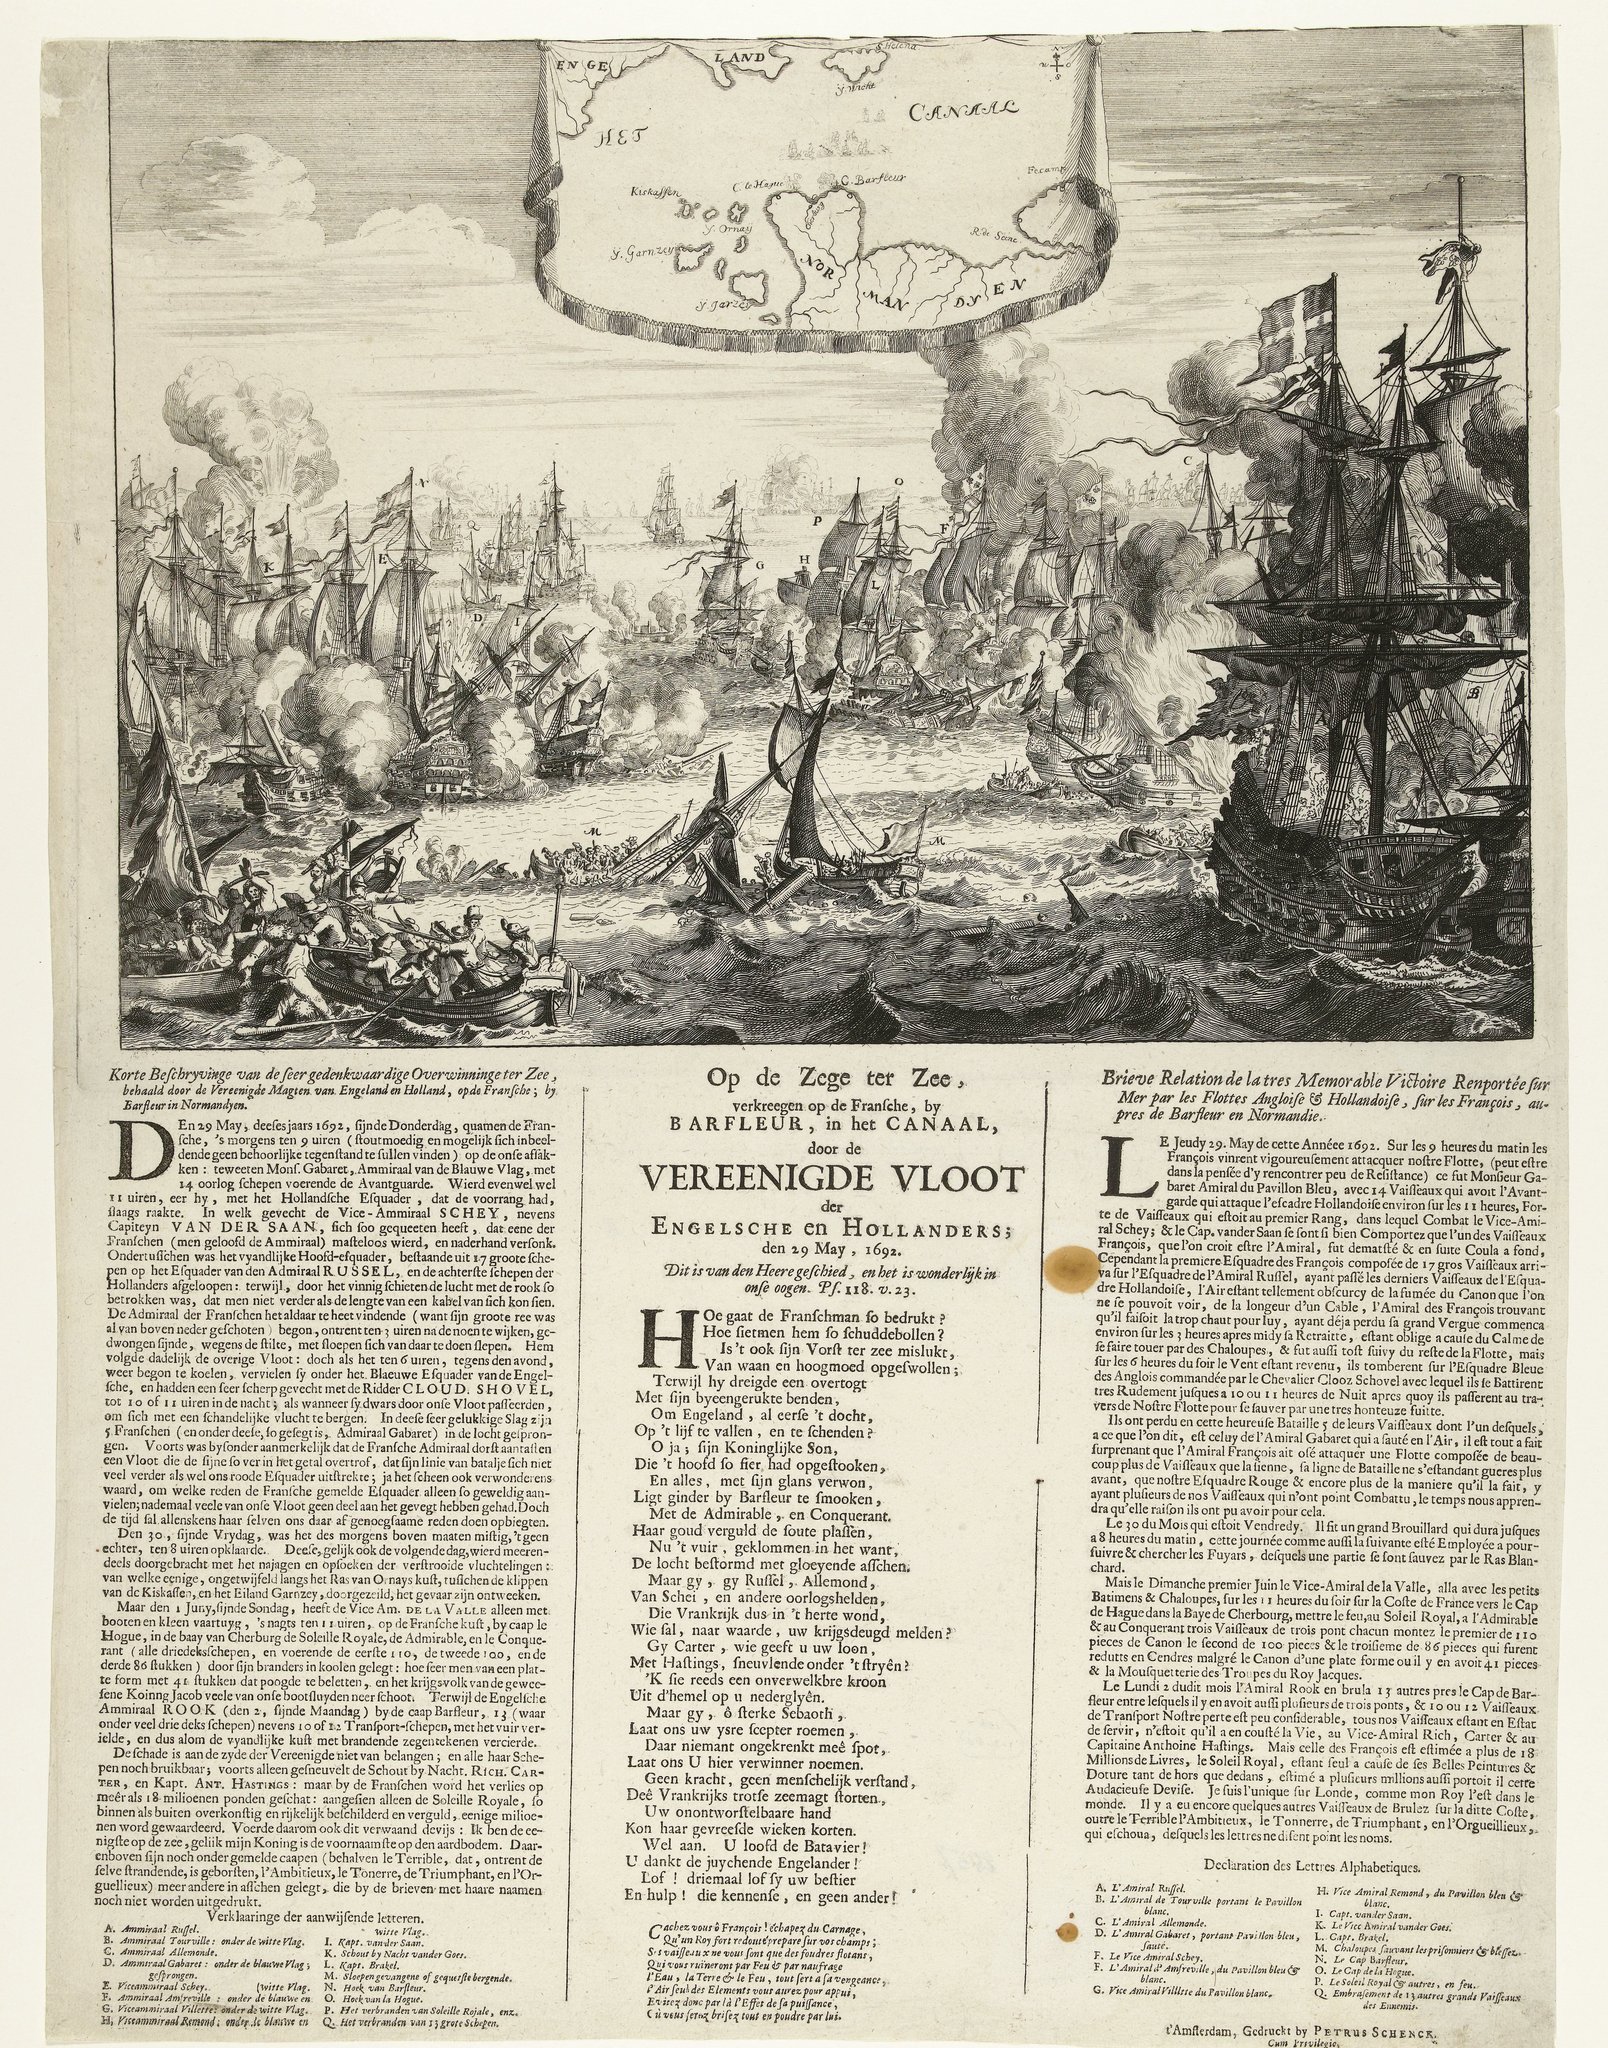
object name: print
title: Zeeslag bij Kaap la Hogue, 1692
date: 1692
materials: paper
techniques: etching, letterpress printing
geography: amsterdam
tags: paris, battle (+ naval force)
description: Zeeslag bij Kaap la Hogue waarbij de Fransen onder admiraal de Tourville werden verslagen door de gecombineerde vloot van Engeland en Holland onder de admiralen Russel en Almonde, 29 mei t/m 3 juni 1692. Op het blad onder de plaat een vers op de overwinning met aan weerszijden beschrijvingen van de slag in het Nederlands en Frans met onderaan de legenda's A-Q.